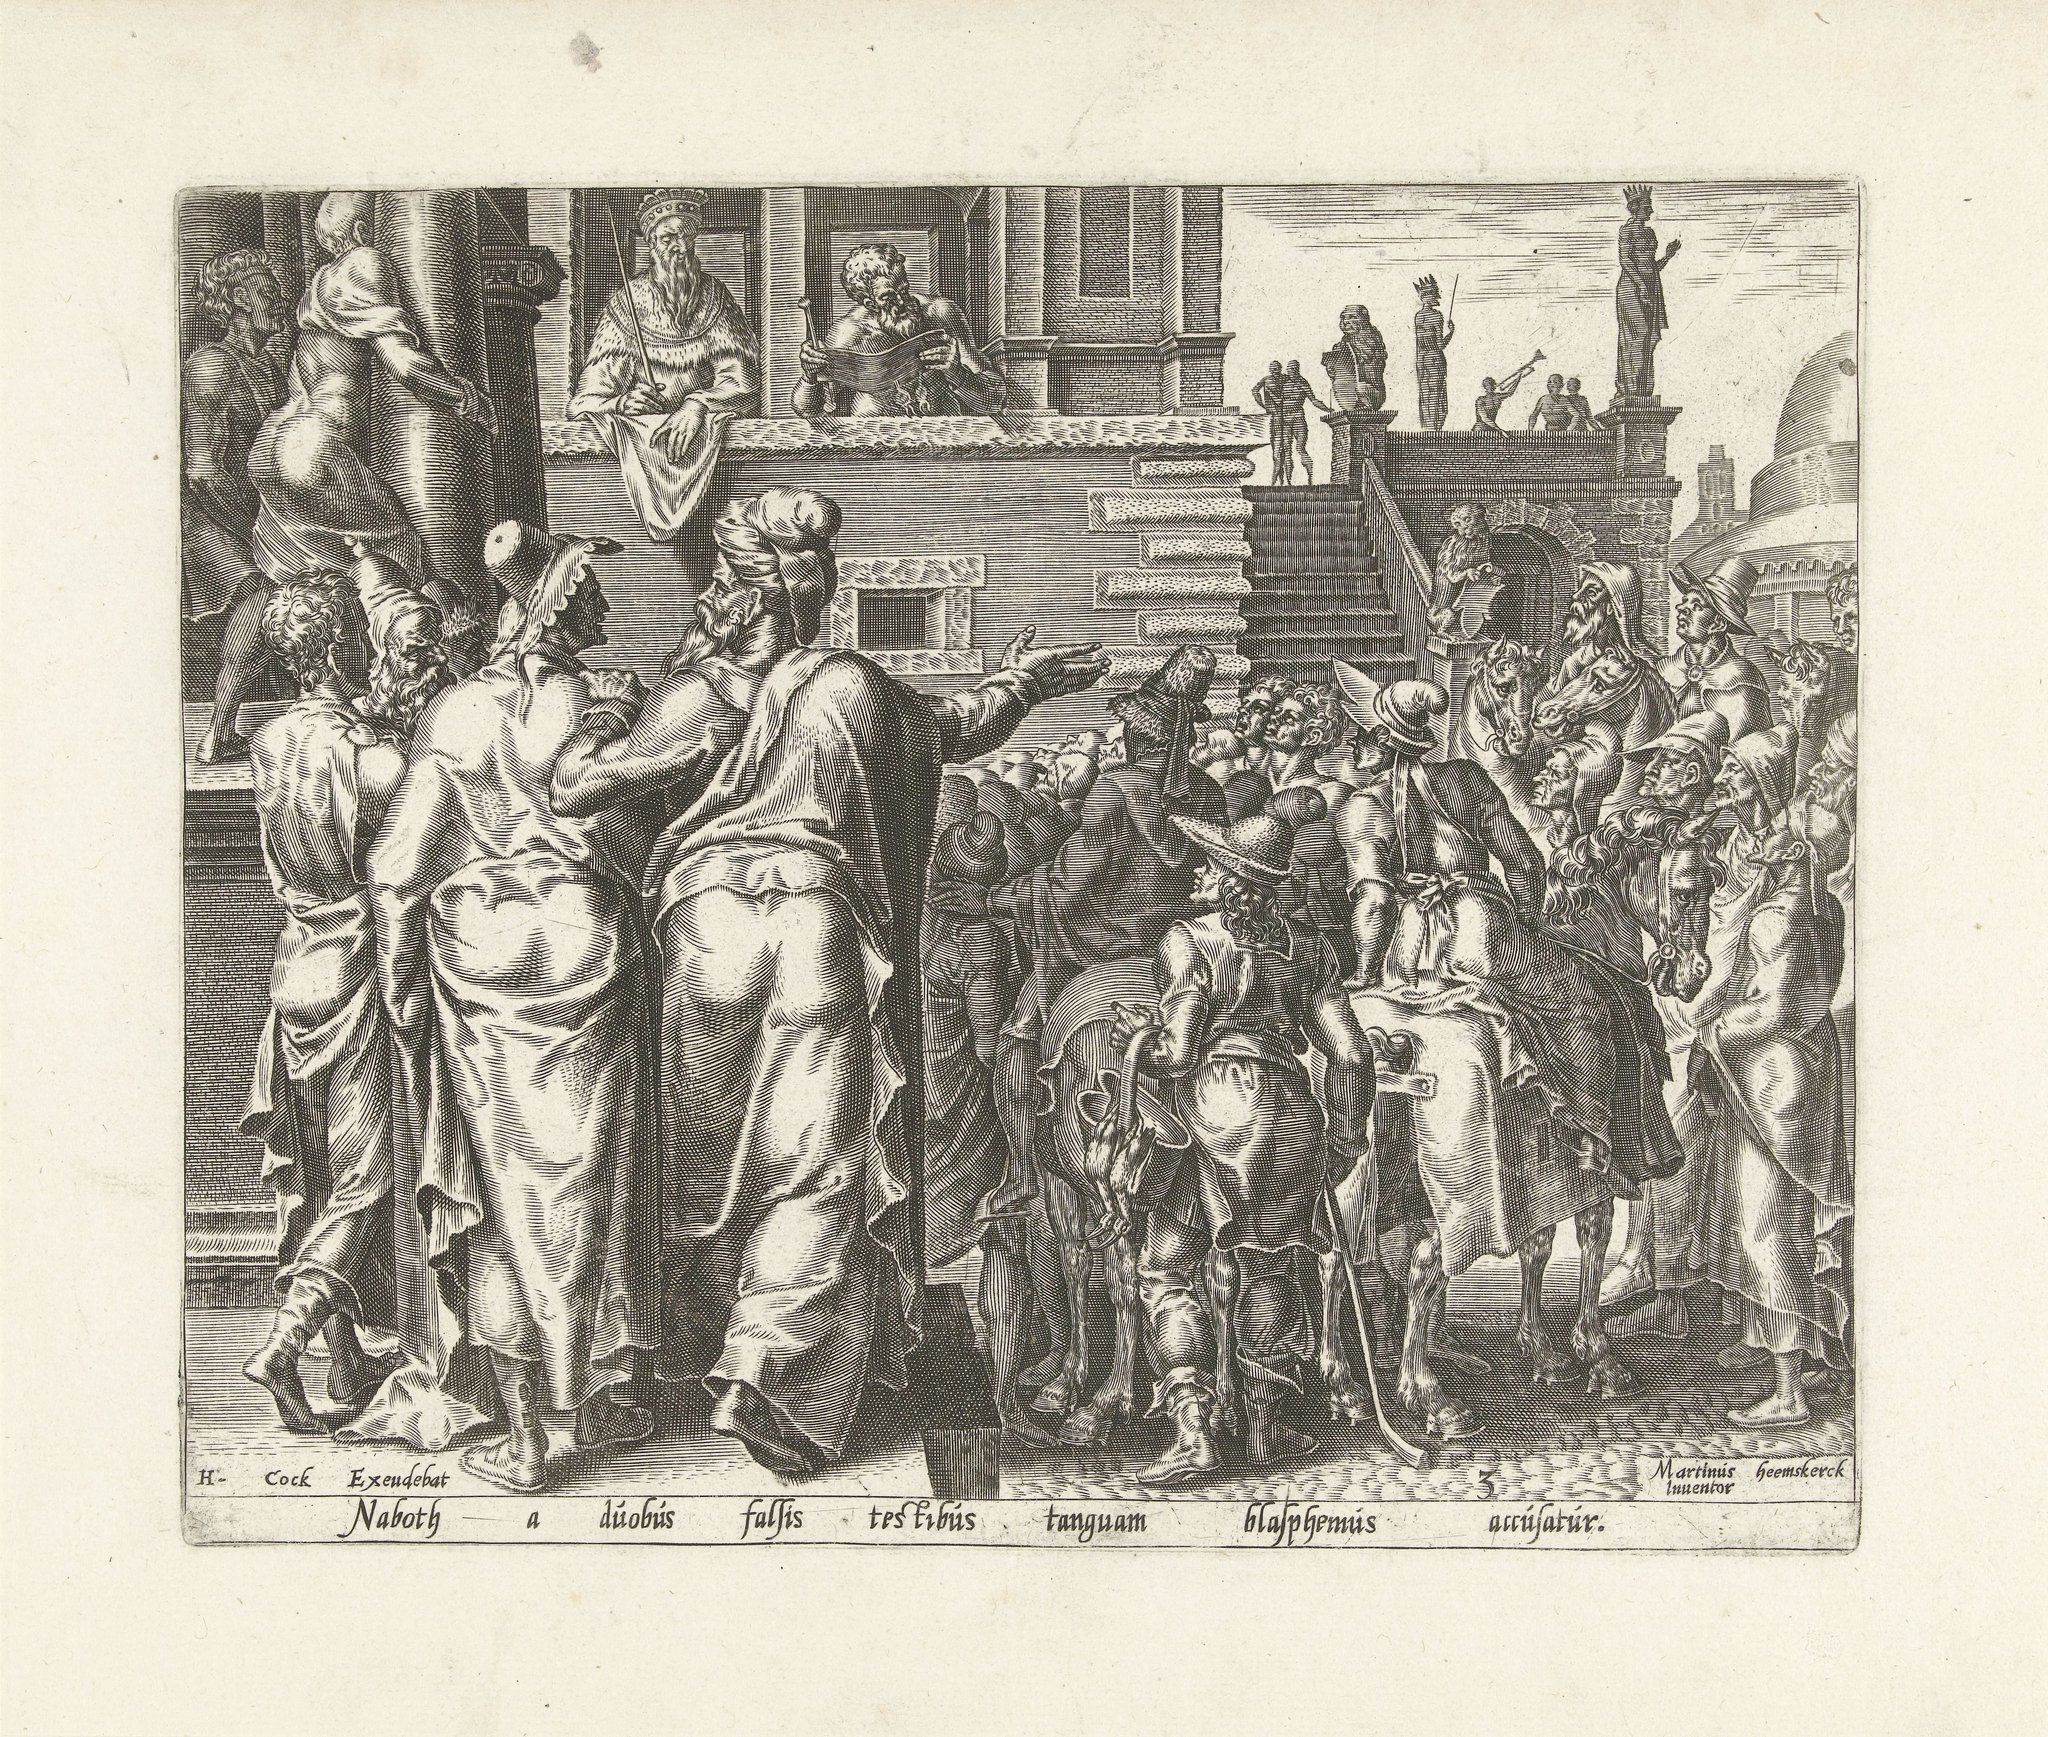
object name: print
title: Geschiedenis van Achab en Nabot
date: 1561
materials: paper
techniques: engraving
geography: haarlem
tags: two men falsely accuse naboth of blasphemy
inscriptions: collector's mark: Lugt 2228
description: Op een plein voor een gebouw is een menigte bijeen. Op de galerij van het gebouw staat een rechter naast een man die een aanklacht opleest. Nabot wordt onterecht beschuldigd van godslastering.